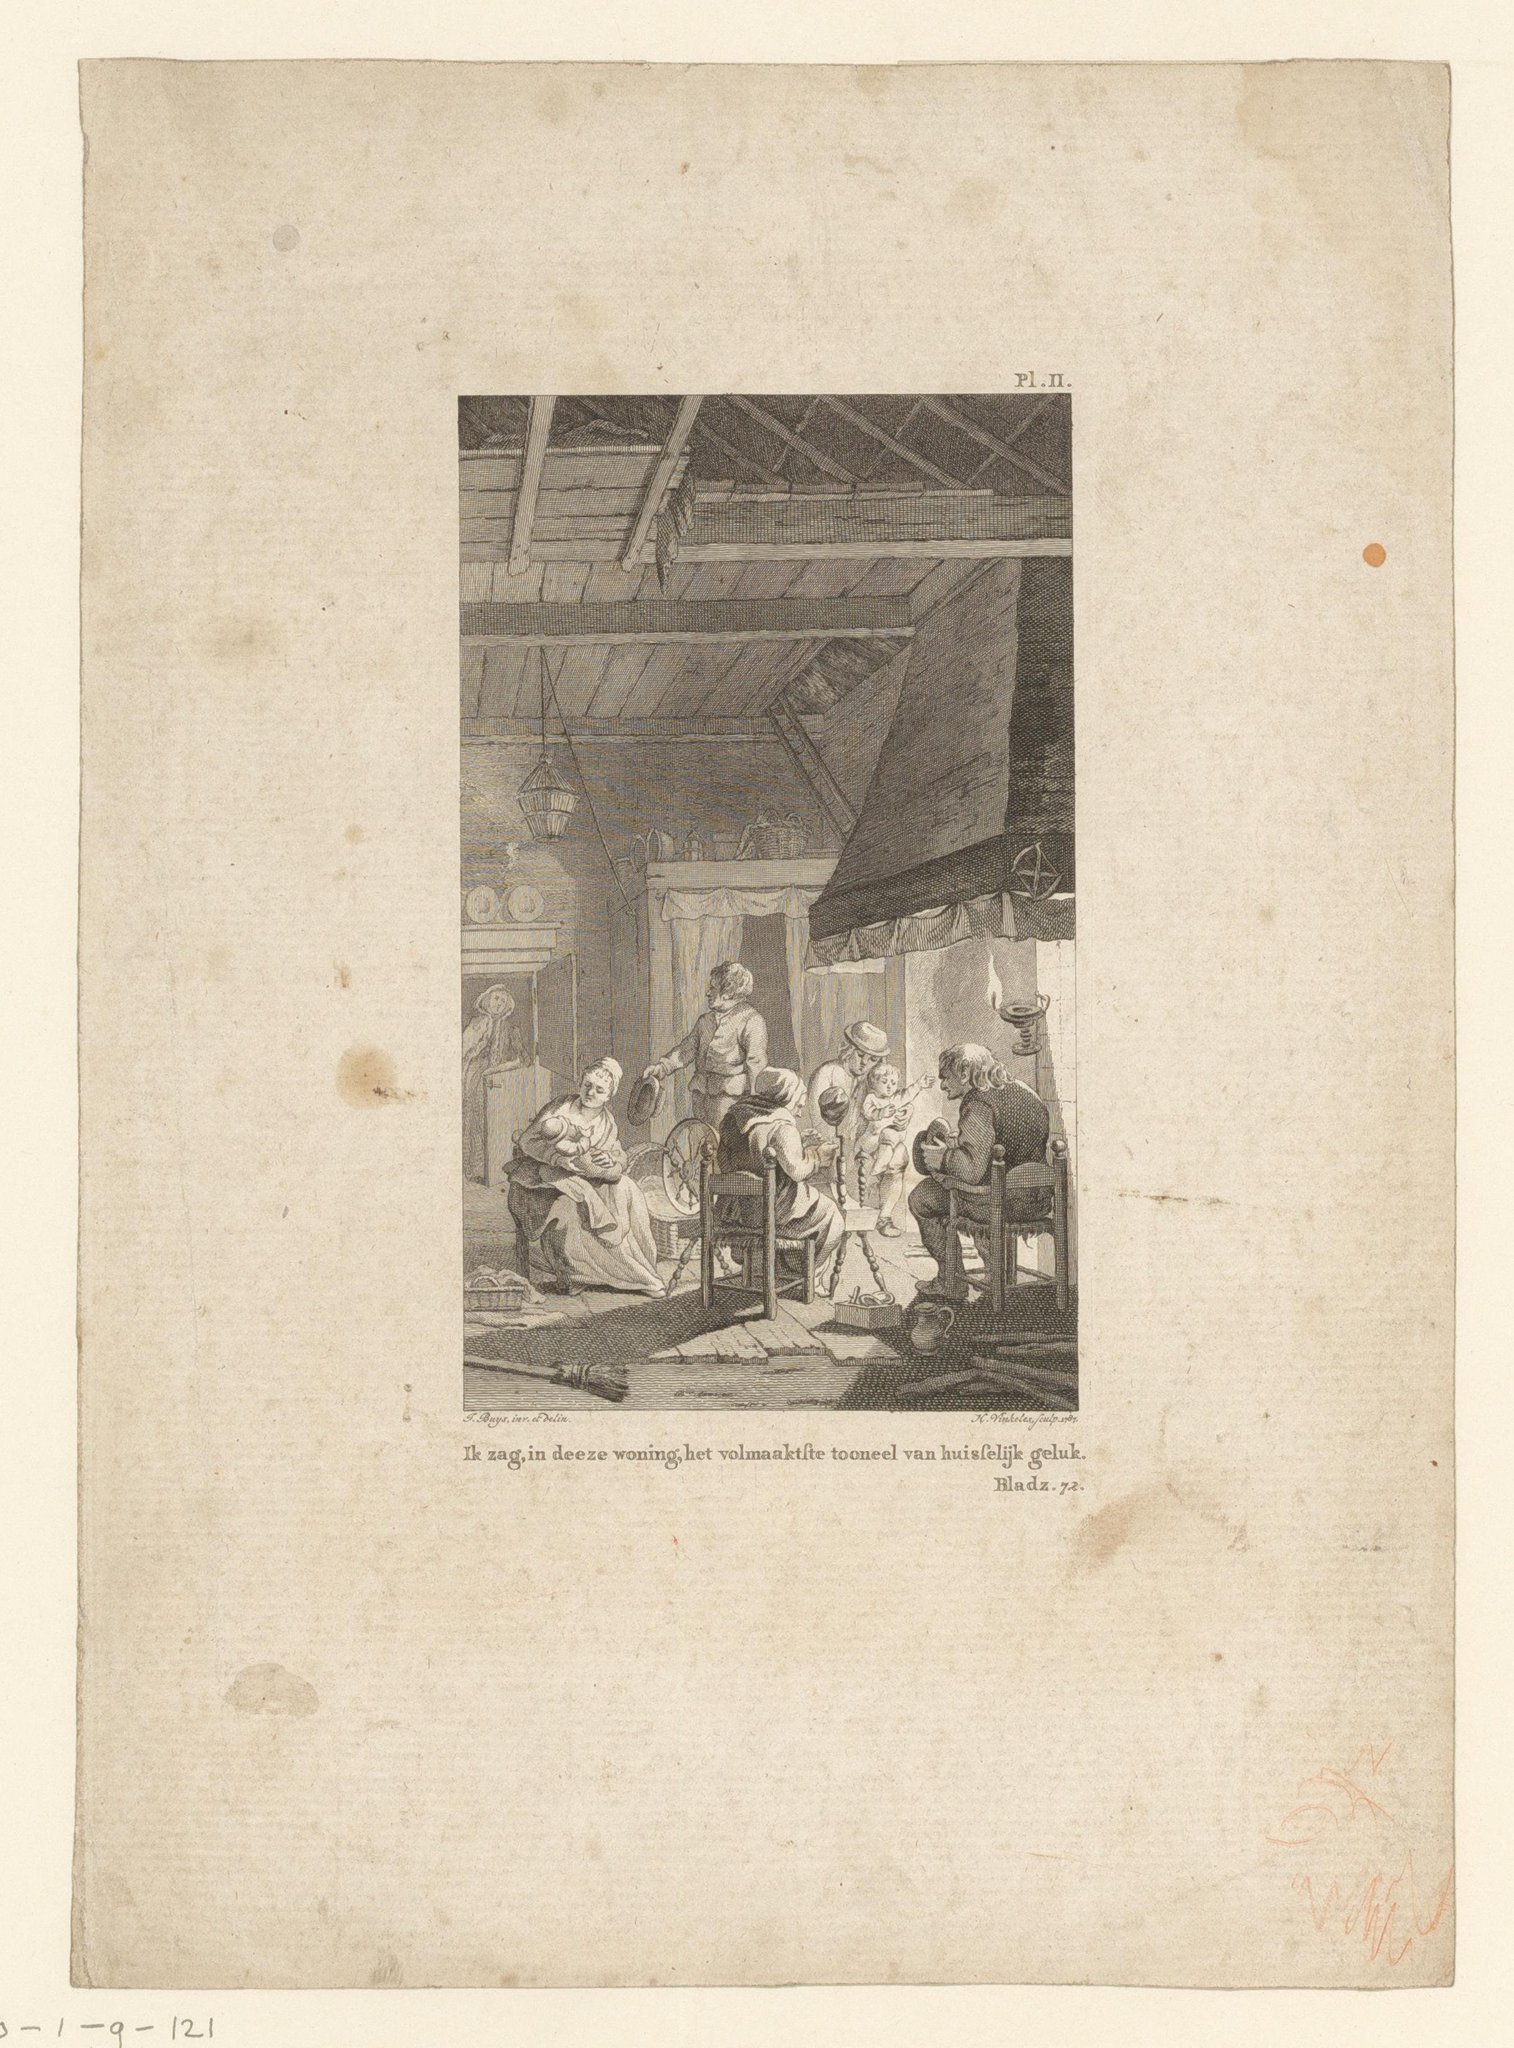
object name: print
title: Ik zag, in deeze woning, het volmaakste tooneel van huiselijk geluk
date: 1787-1788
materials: paper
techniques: engraving, etching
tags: open hearth, fire-place, spinning-wheel, feeding a baby, household chores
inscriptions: stamp, collector's mark: Lugt 1641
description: Rechtsboven genummerd: Pl. II. Rechtsonder genummerd: Bladz. 71. Onderwerpsrubrieken binnen de Atlas Zeden en Gewoonten: Handel, nijverheid en verkeer, Boerenleven.